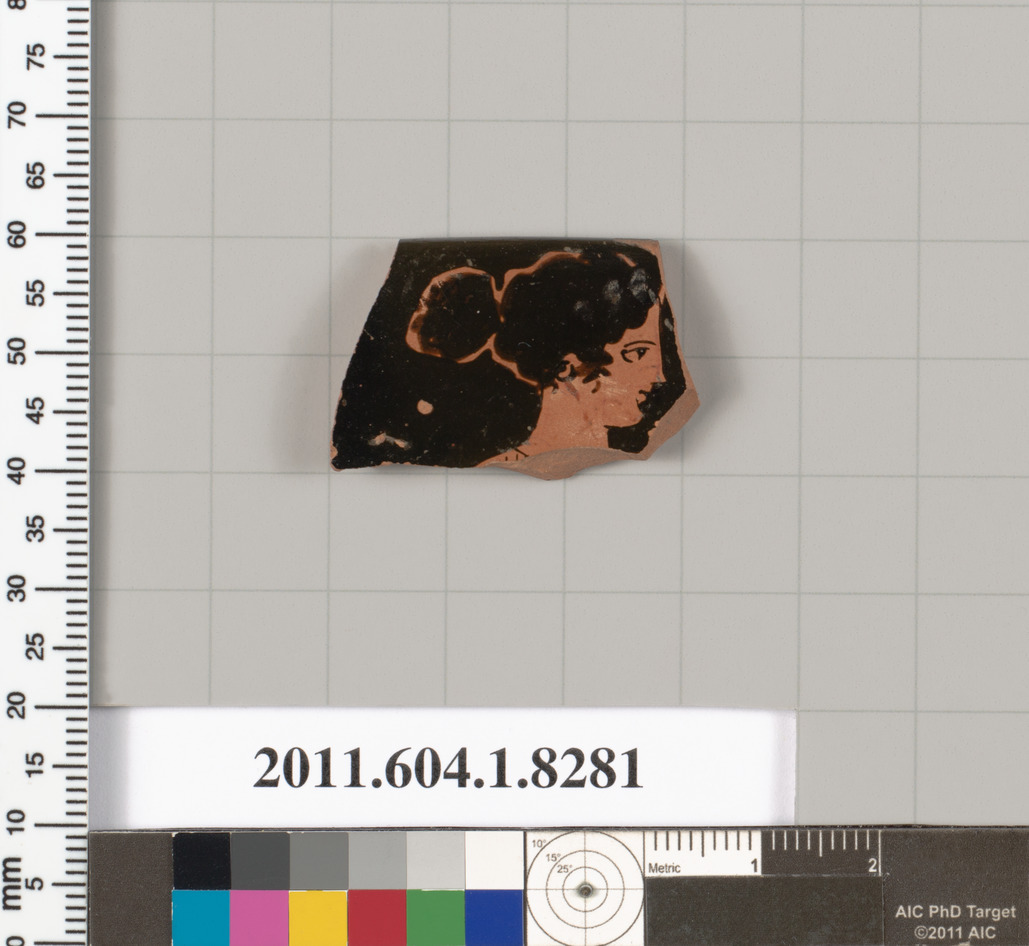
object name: kylix fragment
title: Terracotta rim fragment of a kylix (drinking cup)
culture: greek, attic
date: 420-400 BCE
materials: terracotta